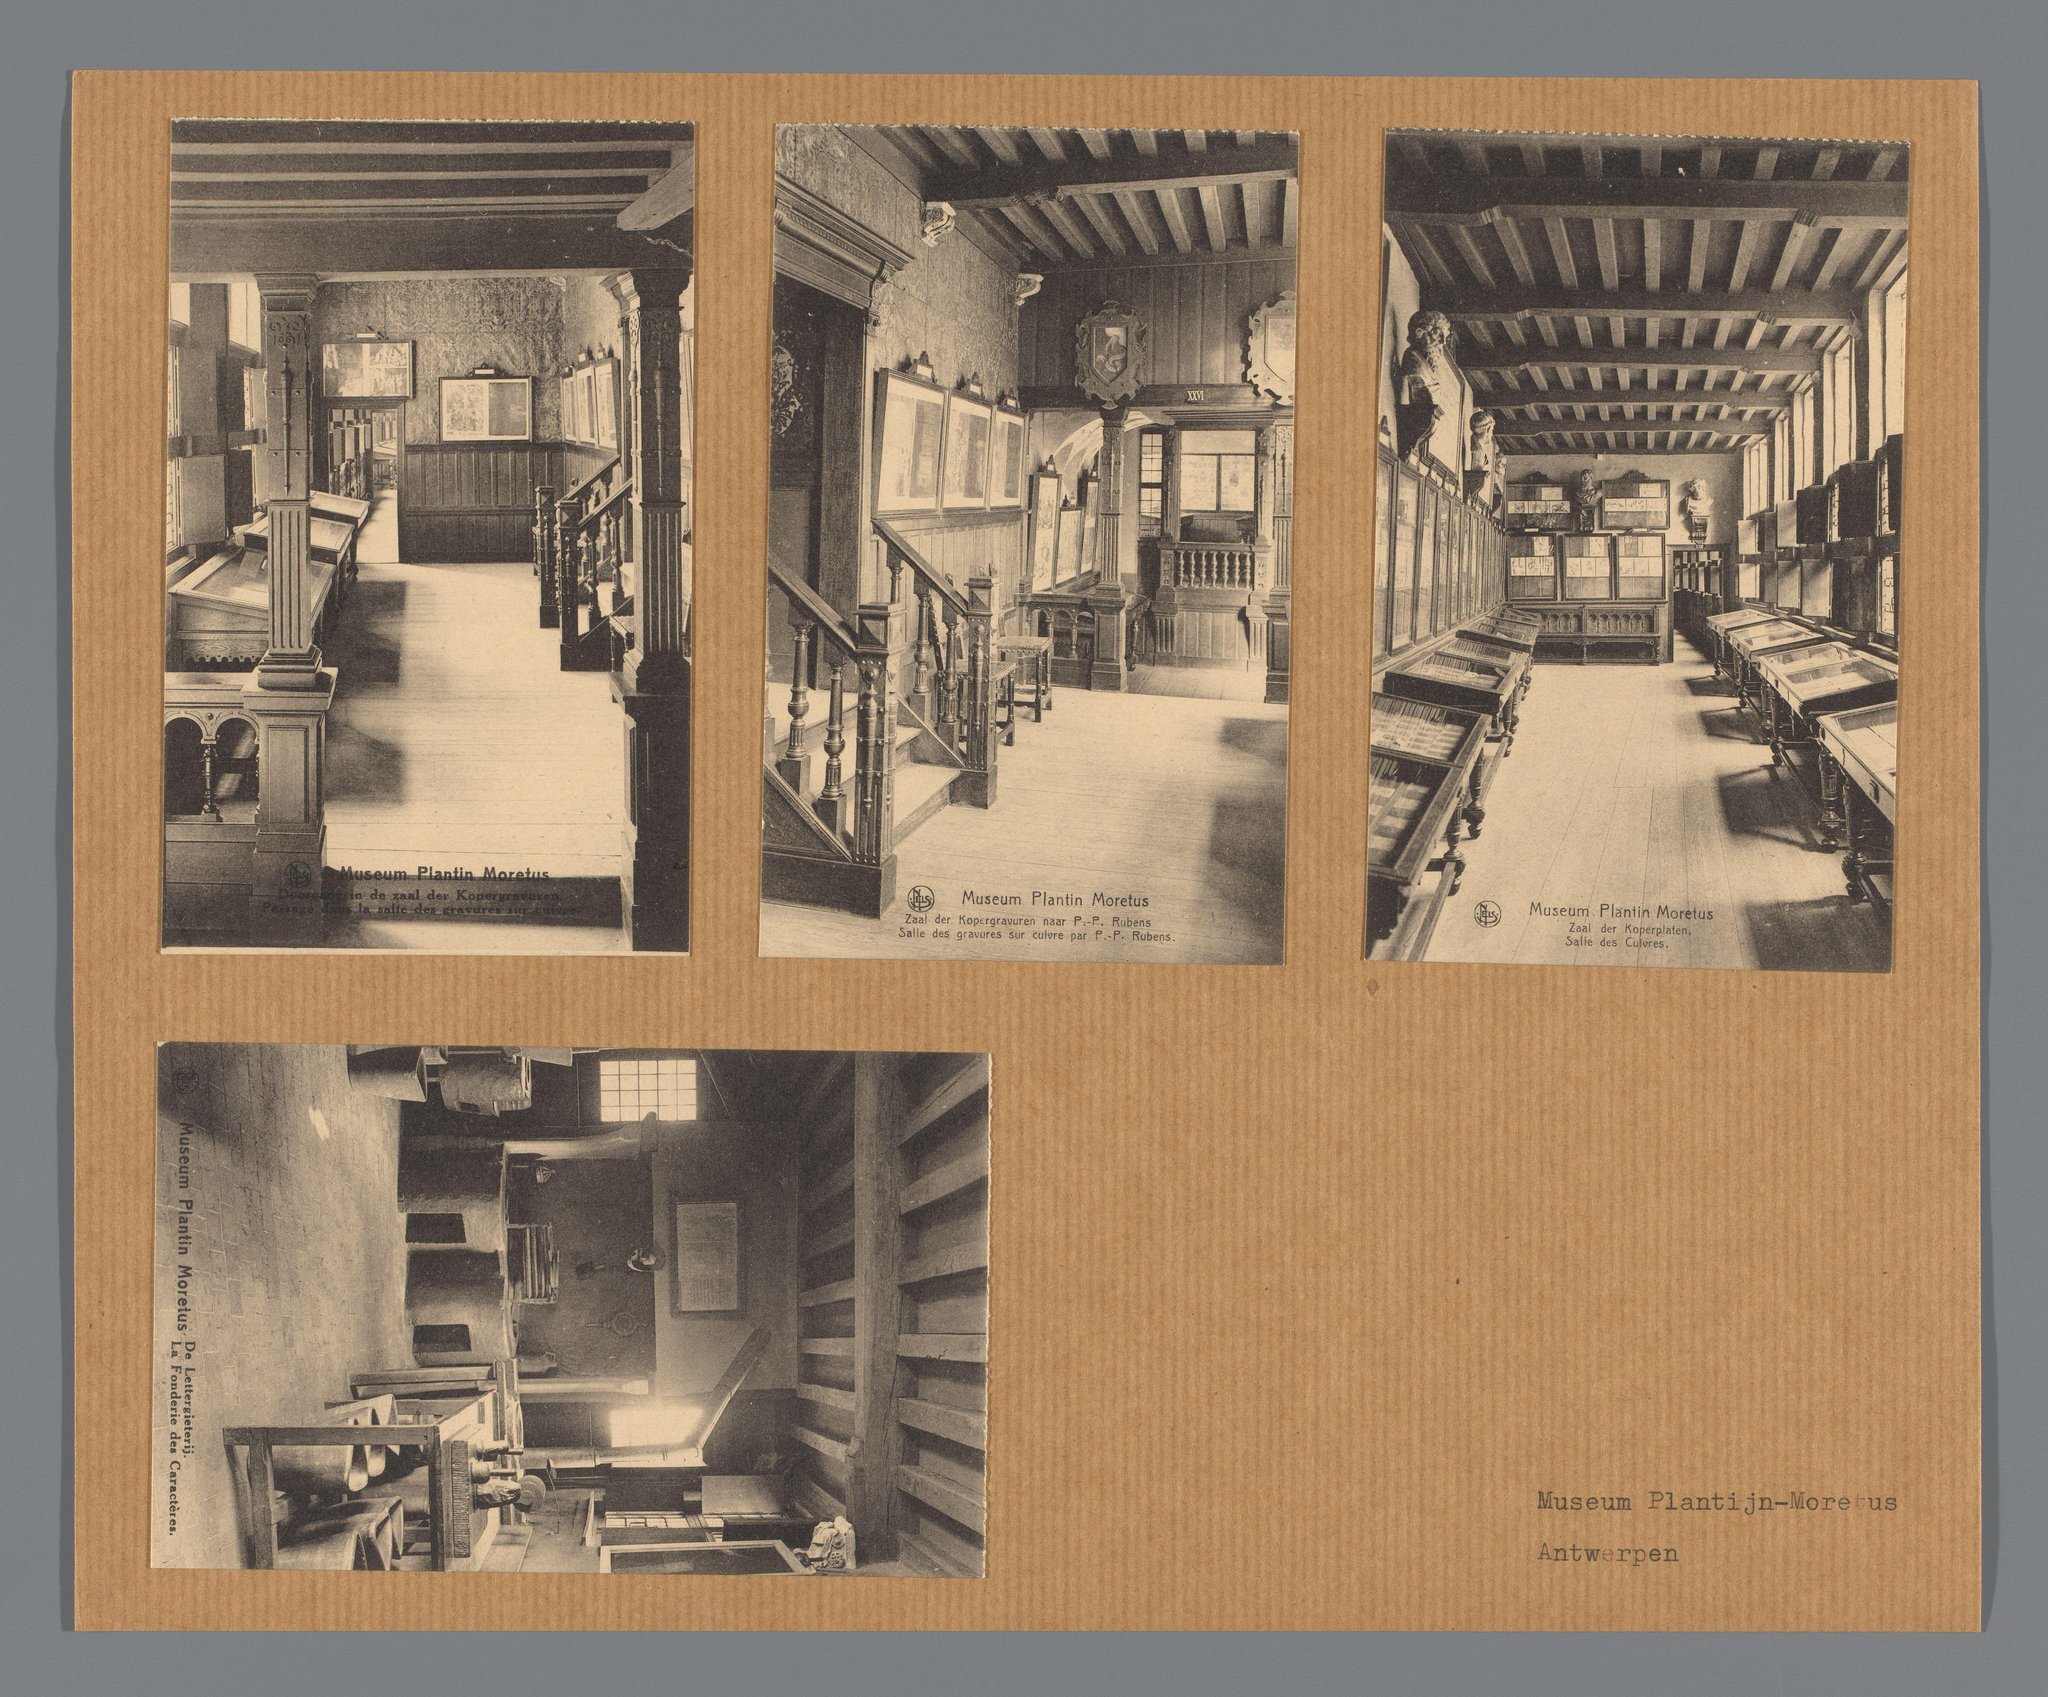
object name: photograph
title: Antwerpen. Museum Plantijn - Moretus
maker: Anonymous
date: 1860-1925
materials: photographic support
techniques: photograph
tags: museum plantin-moretus